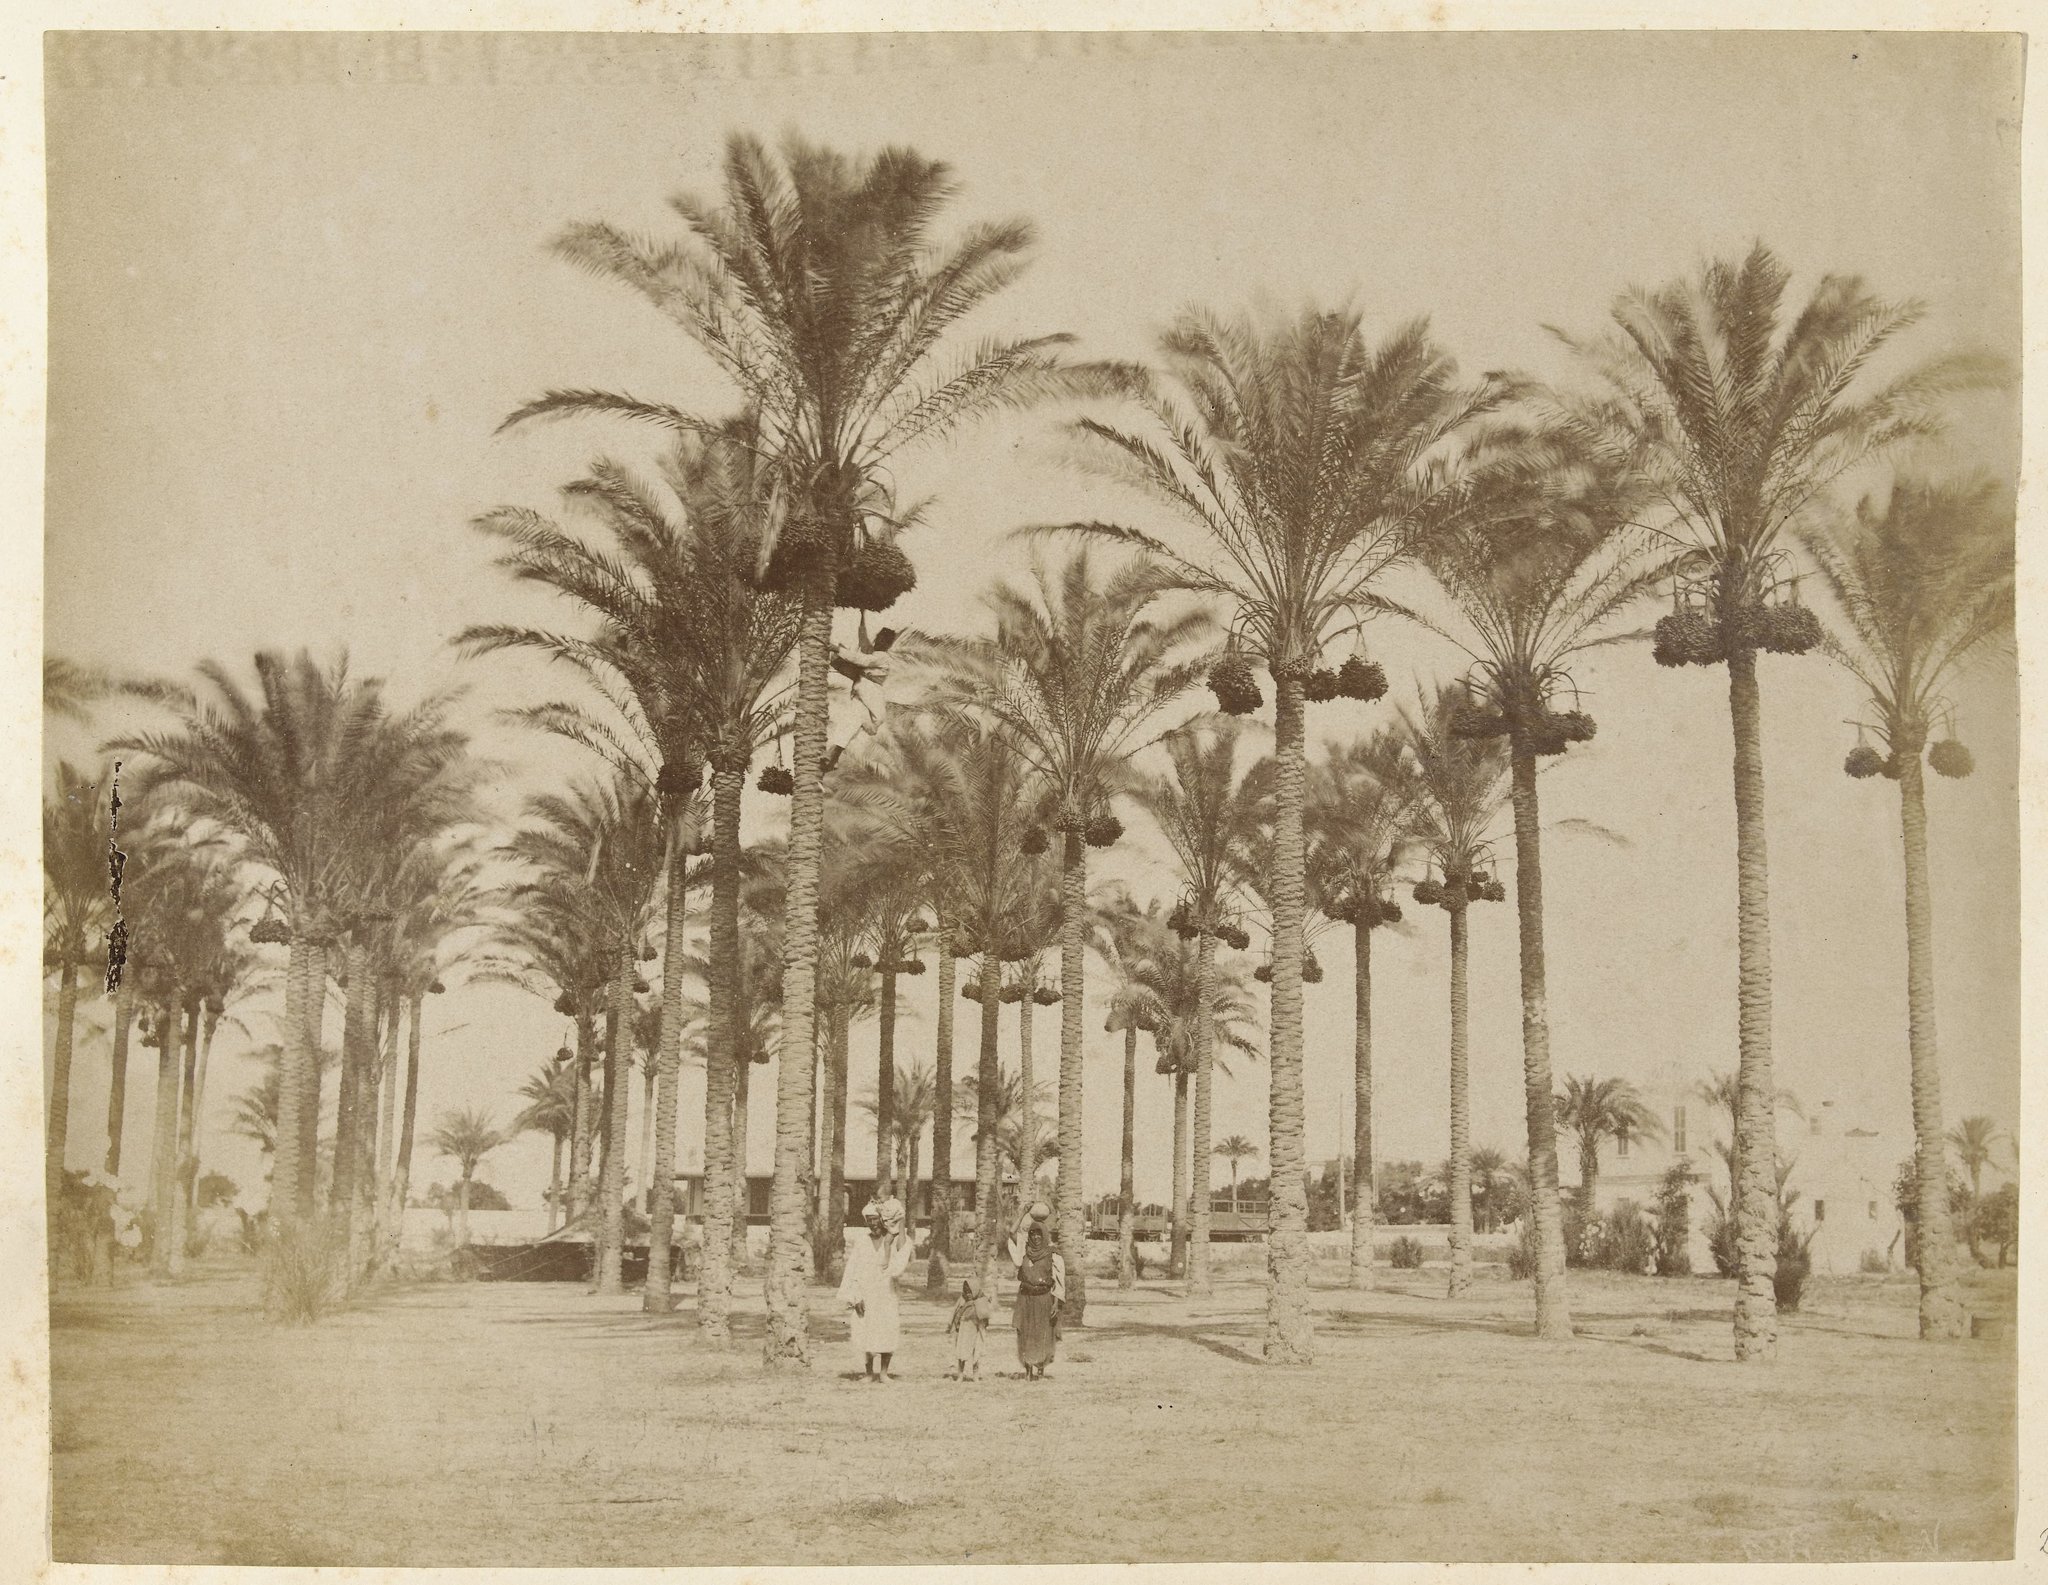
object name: photograph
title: Omgeving van Alexandrië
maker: Anonymous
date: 1890-1910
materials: cardboard, paper, photographic support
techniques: gelatin silver print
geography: netherlands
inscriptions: caption: ‘In de omstreken van Alexandrië’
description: Een gesluierde vrouw met een waterkruik en een man met twee kinderen op zijn arm lopen door de palmentuin.